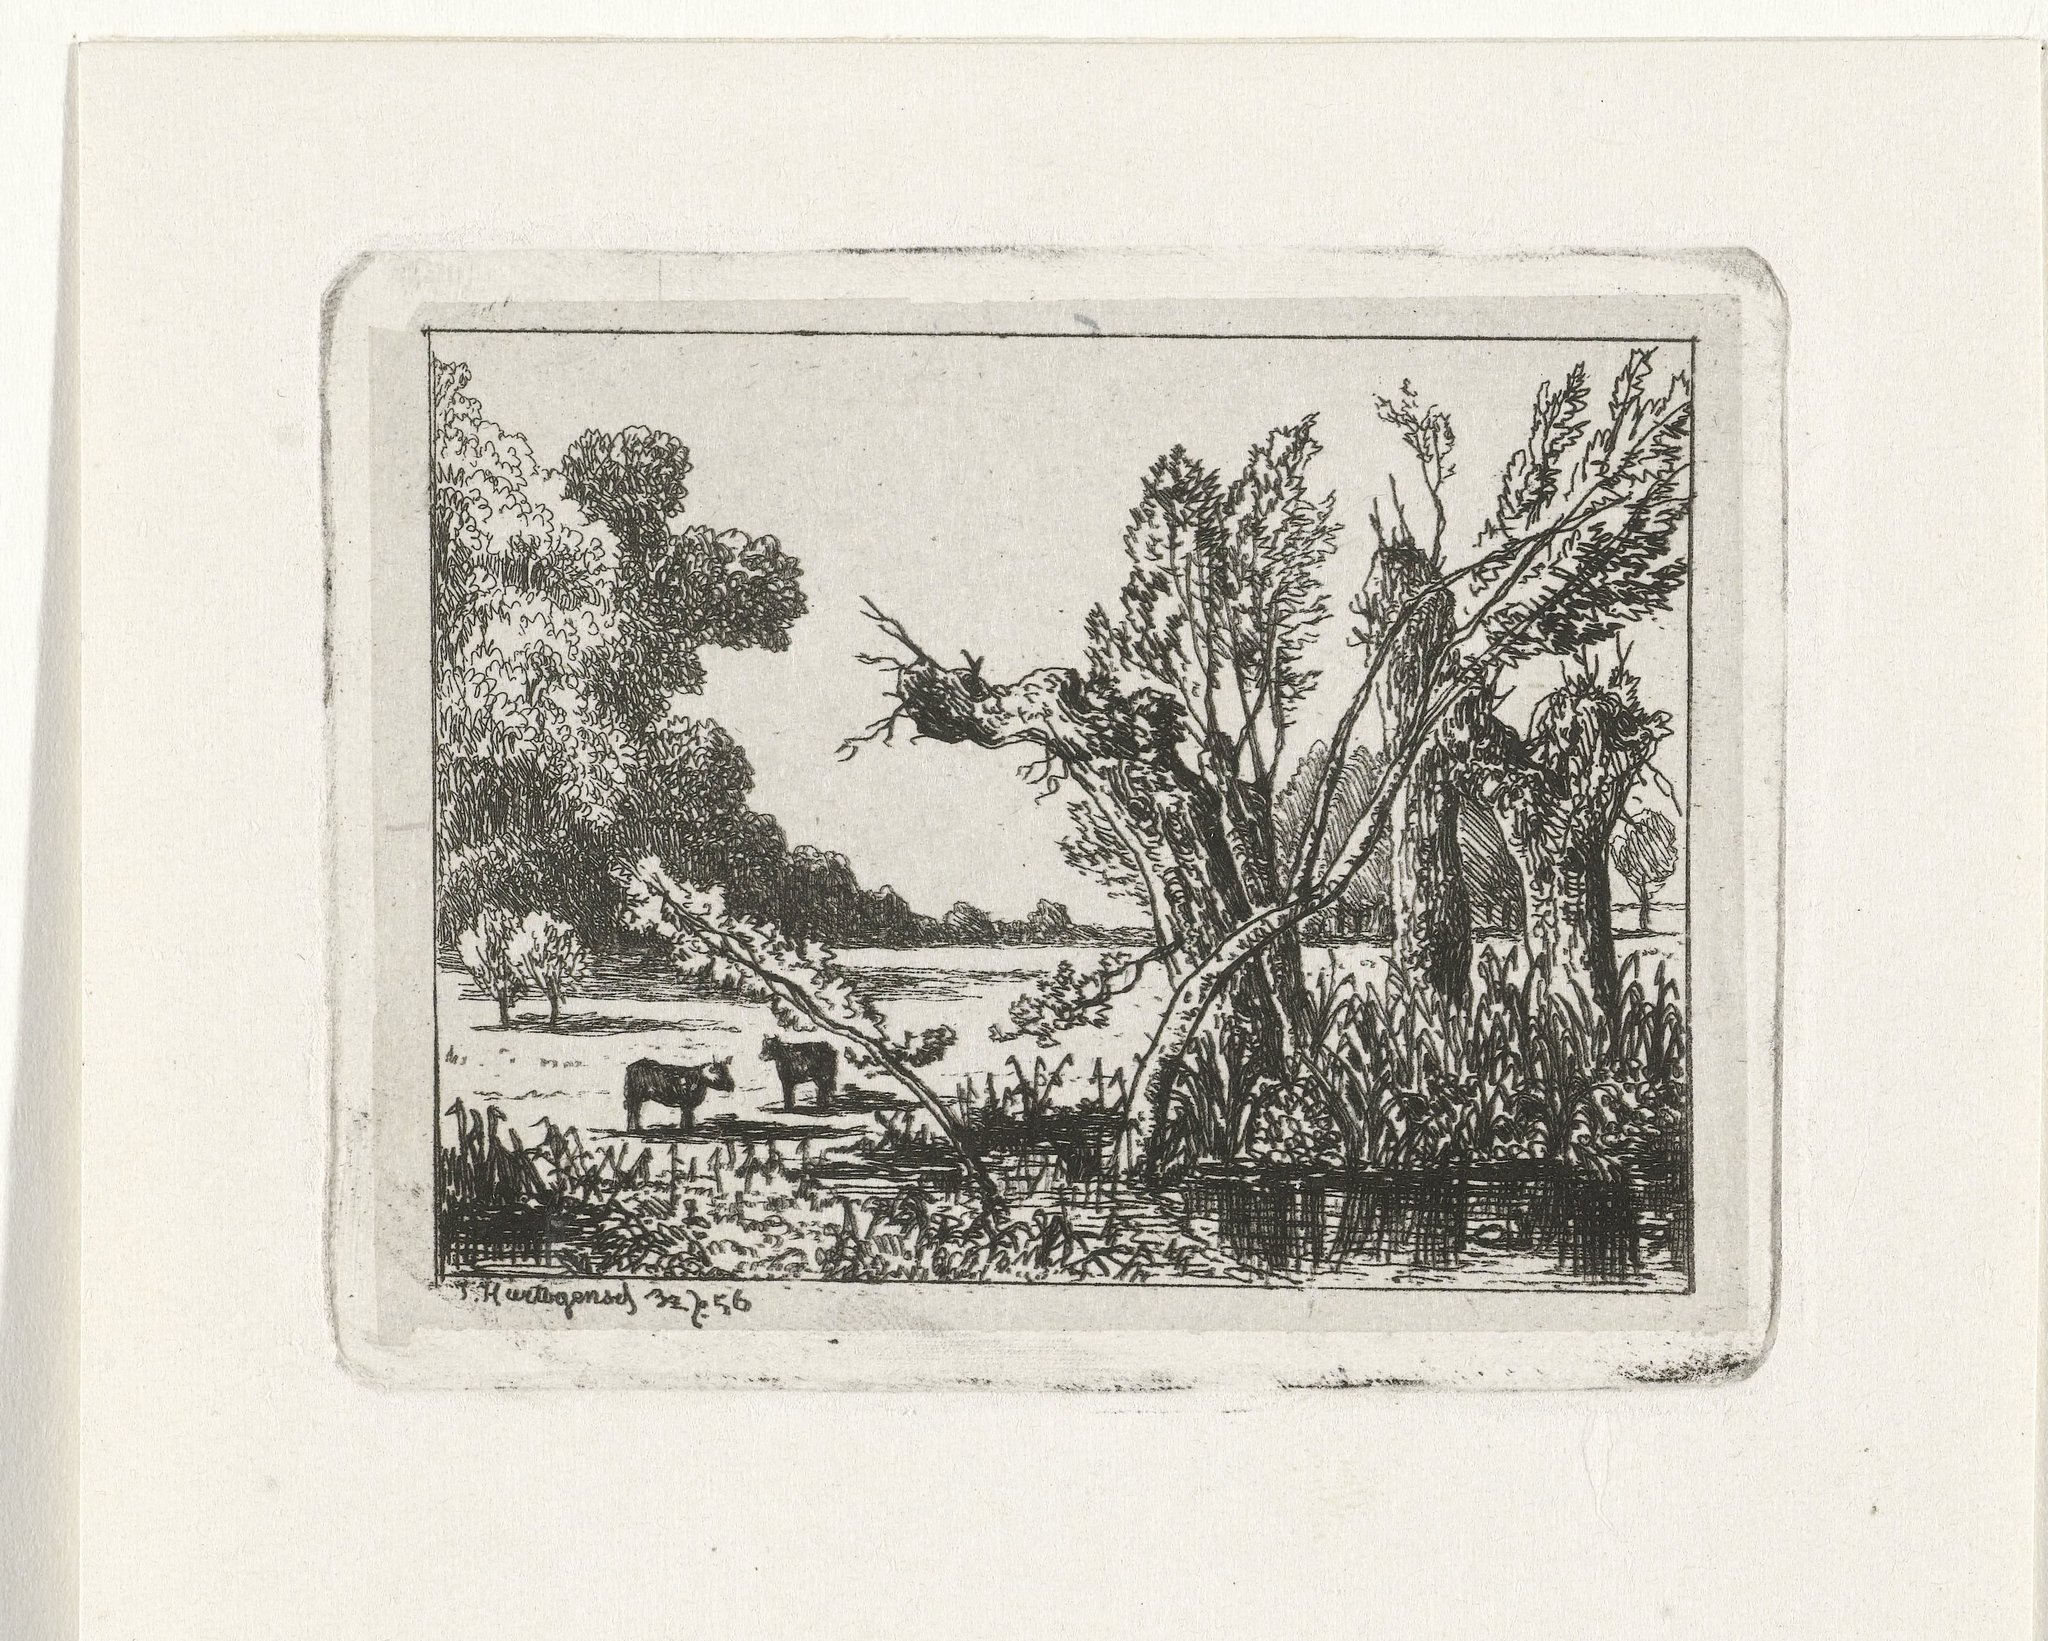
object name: print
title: Landschap te Oosterbeek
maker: joseph hartogensis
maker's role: painter, print maker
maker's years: 1822-1865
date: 1856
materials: paper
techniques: etching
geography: the hague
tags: landscapes with waters, waterscapes, seascapes (in the temperate zone), trees: willow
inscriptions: collector's mark: Lugt 2228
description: Landschap met rechts knotwilgen aan een waterkant. Links in een weiland twee koeien.